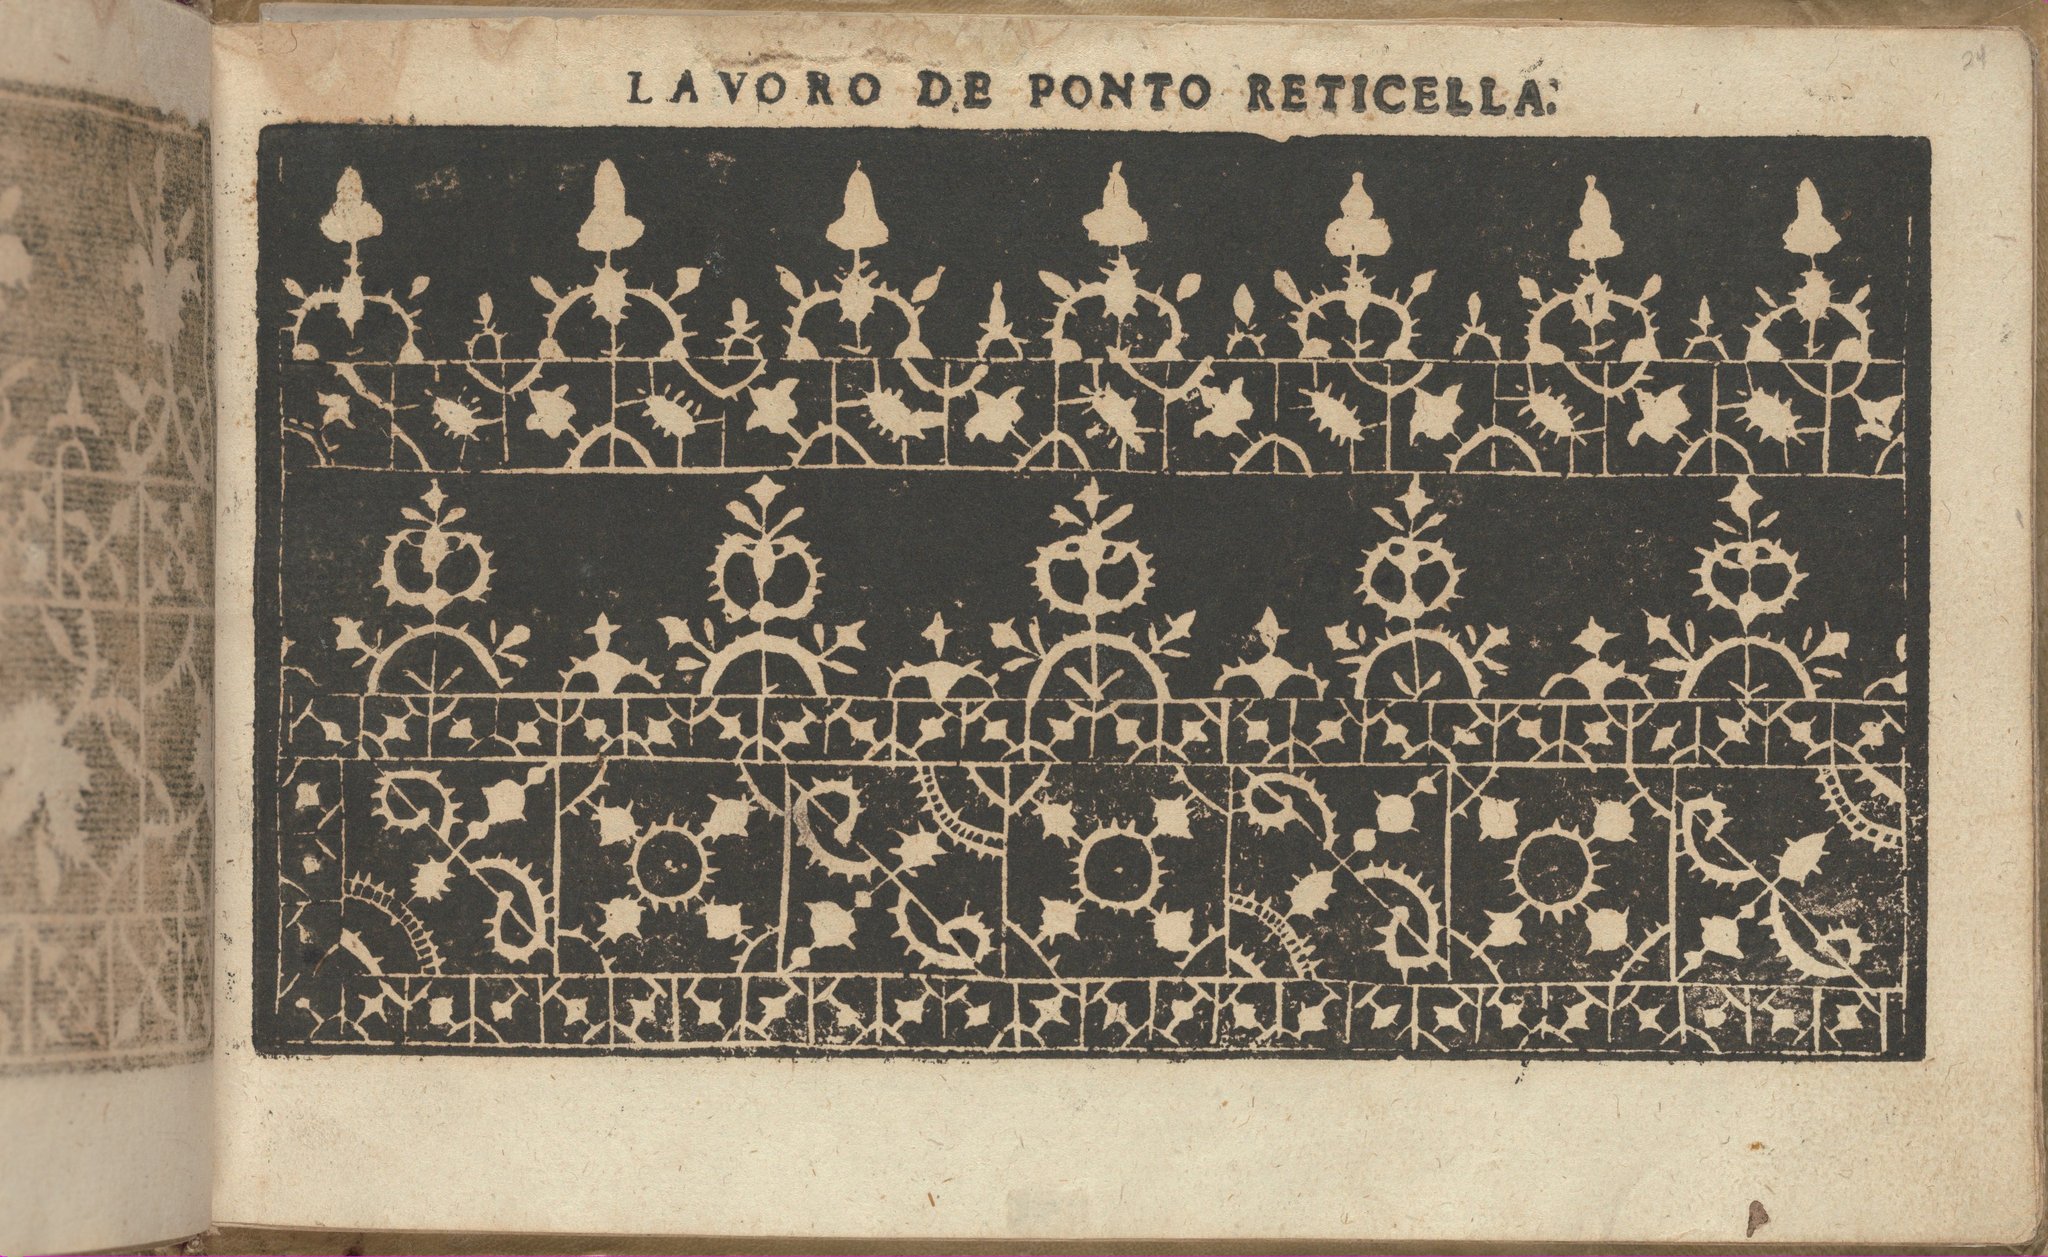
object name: book print ornament architecture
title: Studio delle virtuose Dame, page 24 (recto)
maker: isabella catanea parasole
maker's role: designer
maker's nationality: italian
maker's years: 1565-1625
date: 1597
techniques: woodcut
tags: ornament